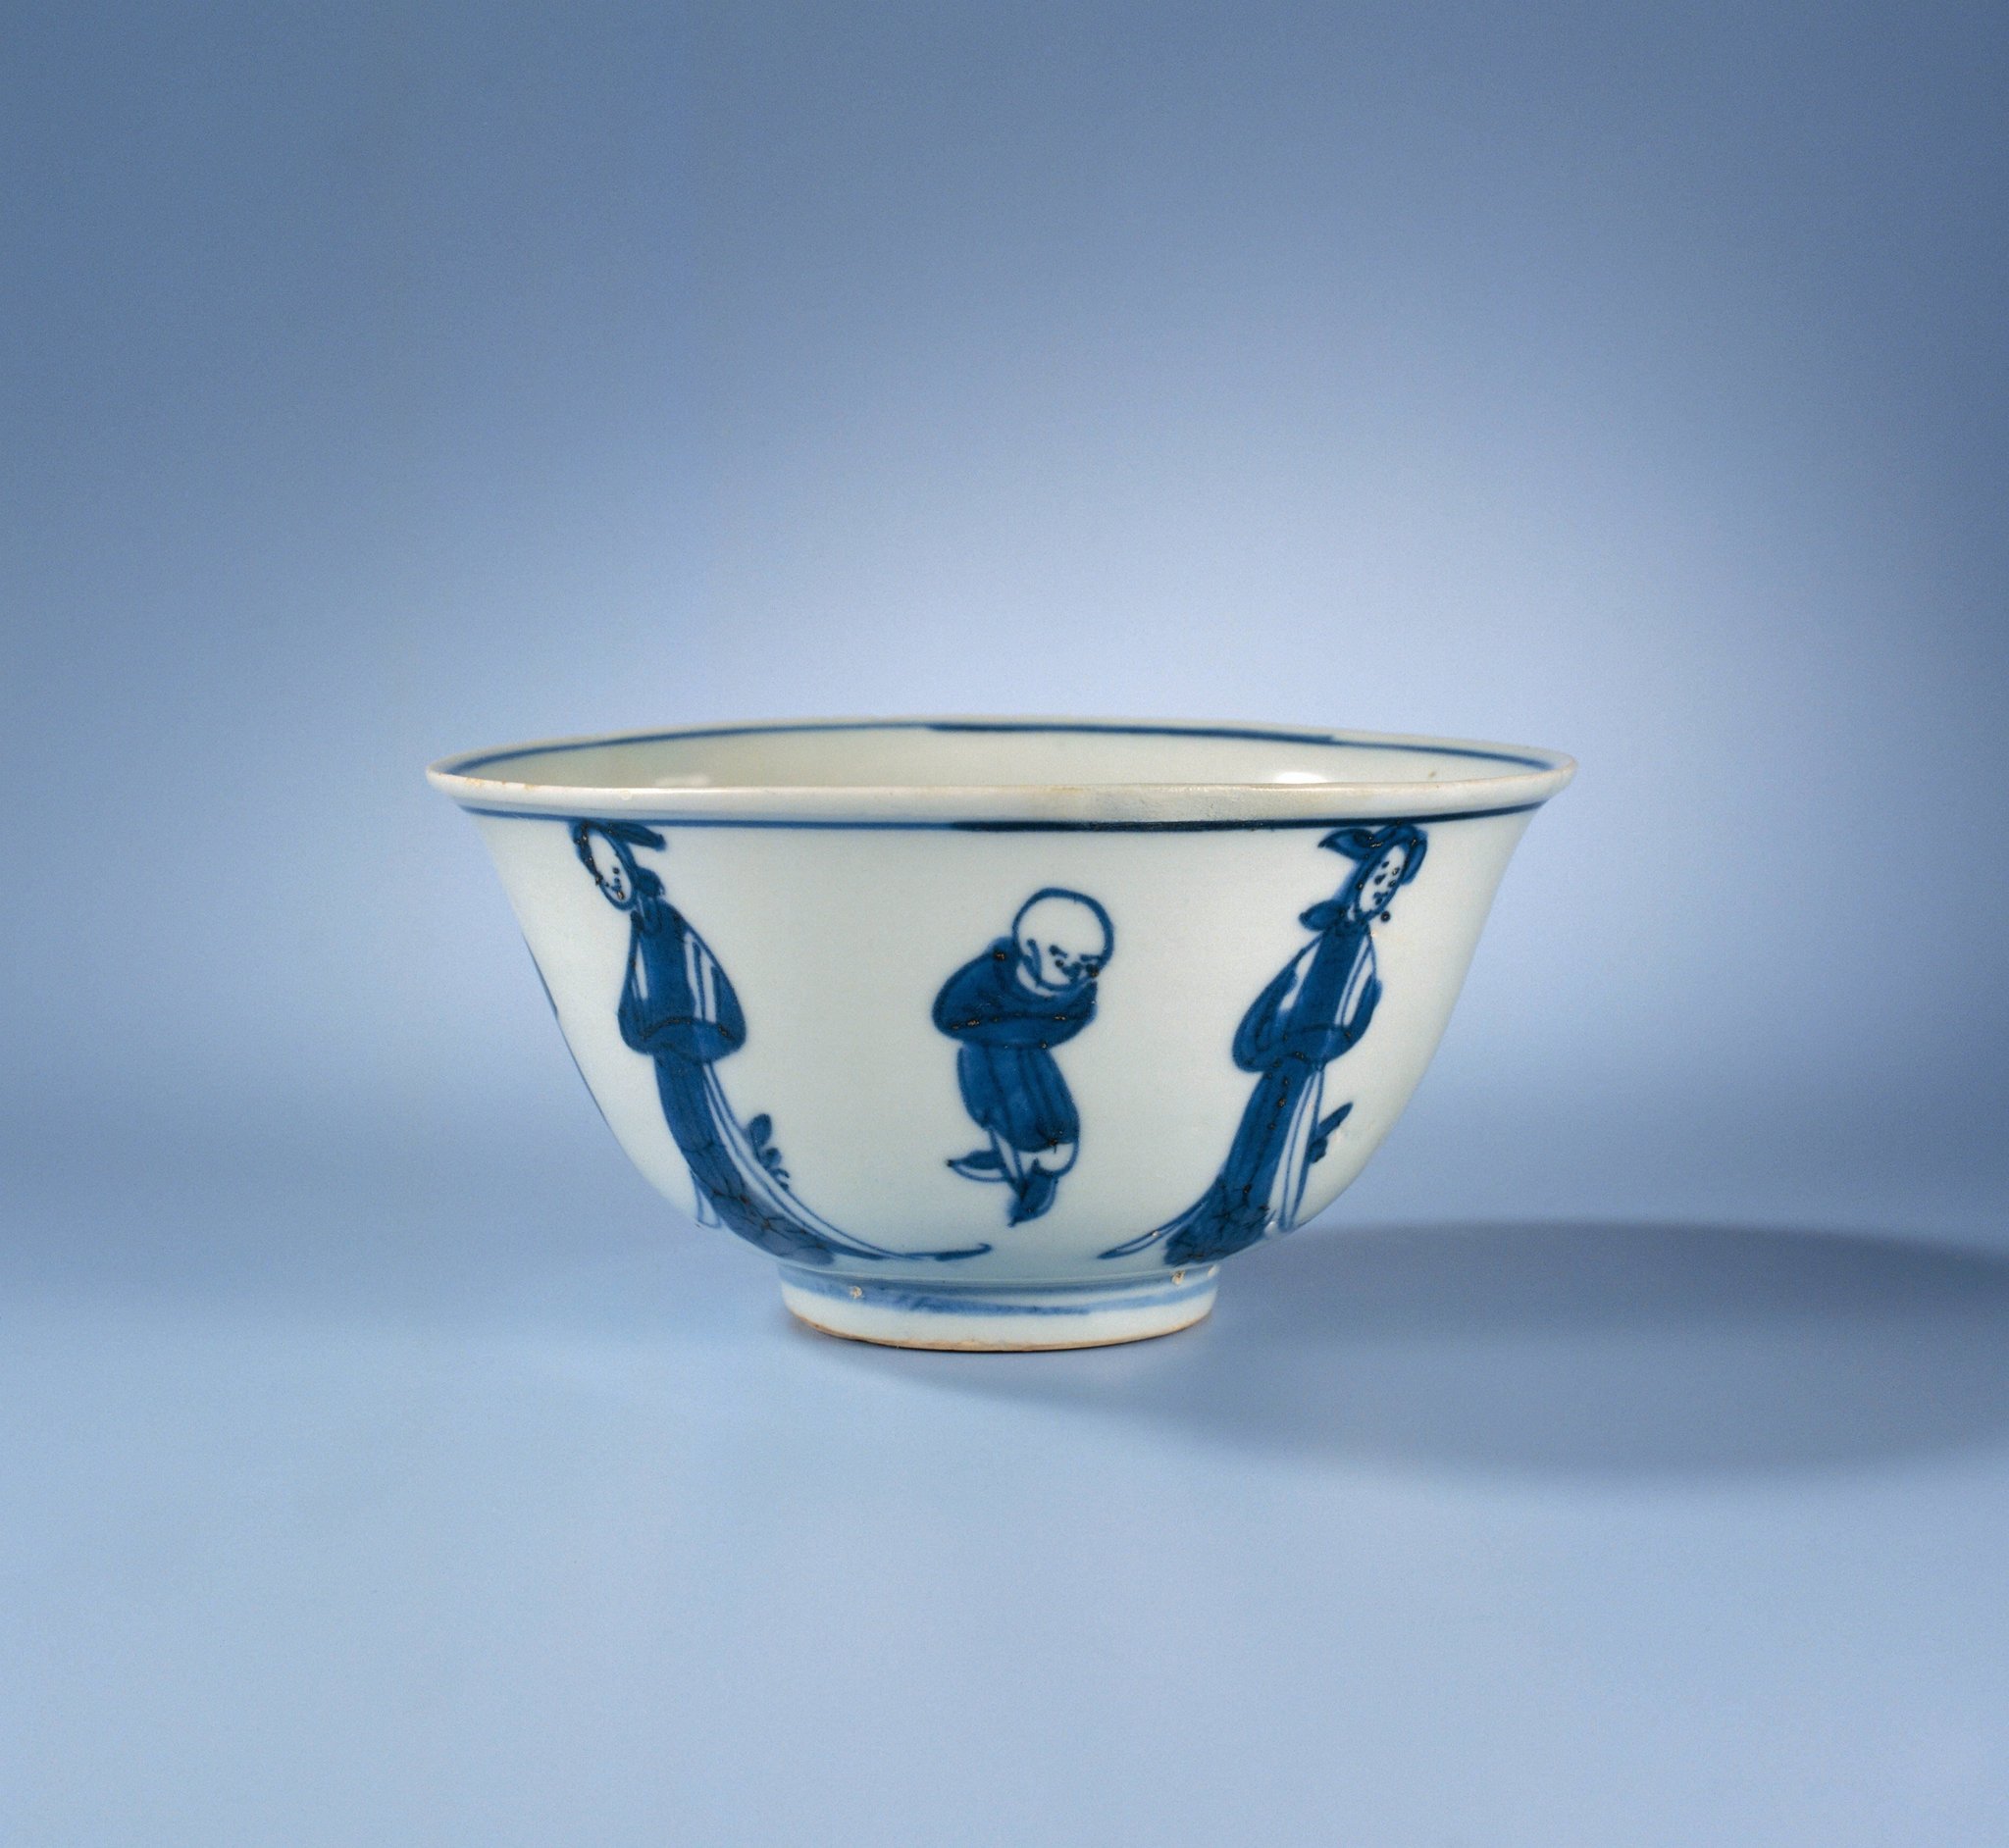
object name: bowl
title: Bowl with a scholar, four women and boys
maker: Anonymous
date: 1575-1599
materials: cobalt, glaze, paint, porcelain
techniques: firing, turning, vitrification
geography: china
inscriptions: mark: ‘chang chun jia qi’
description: Kom op voetring en uitspreidende rand. Gedecoreerd in onderglazuur blauw, met aan de buitenzijde de voorstelling van vier vrouwenfiguren en kinderen. In het midden van de binnenzijde van de kom een staande geleerde in een cirkel. Gemerkt op de bodem met een vier-karaktermerk, wat zich laat lezen als 'chang chun jia qi' -hetgeen betekent 'fraaie kom en eeuwigdurende lente'.